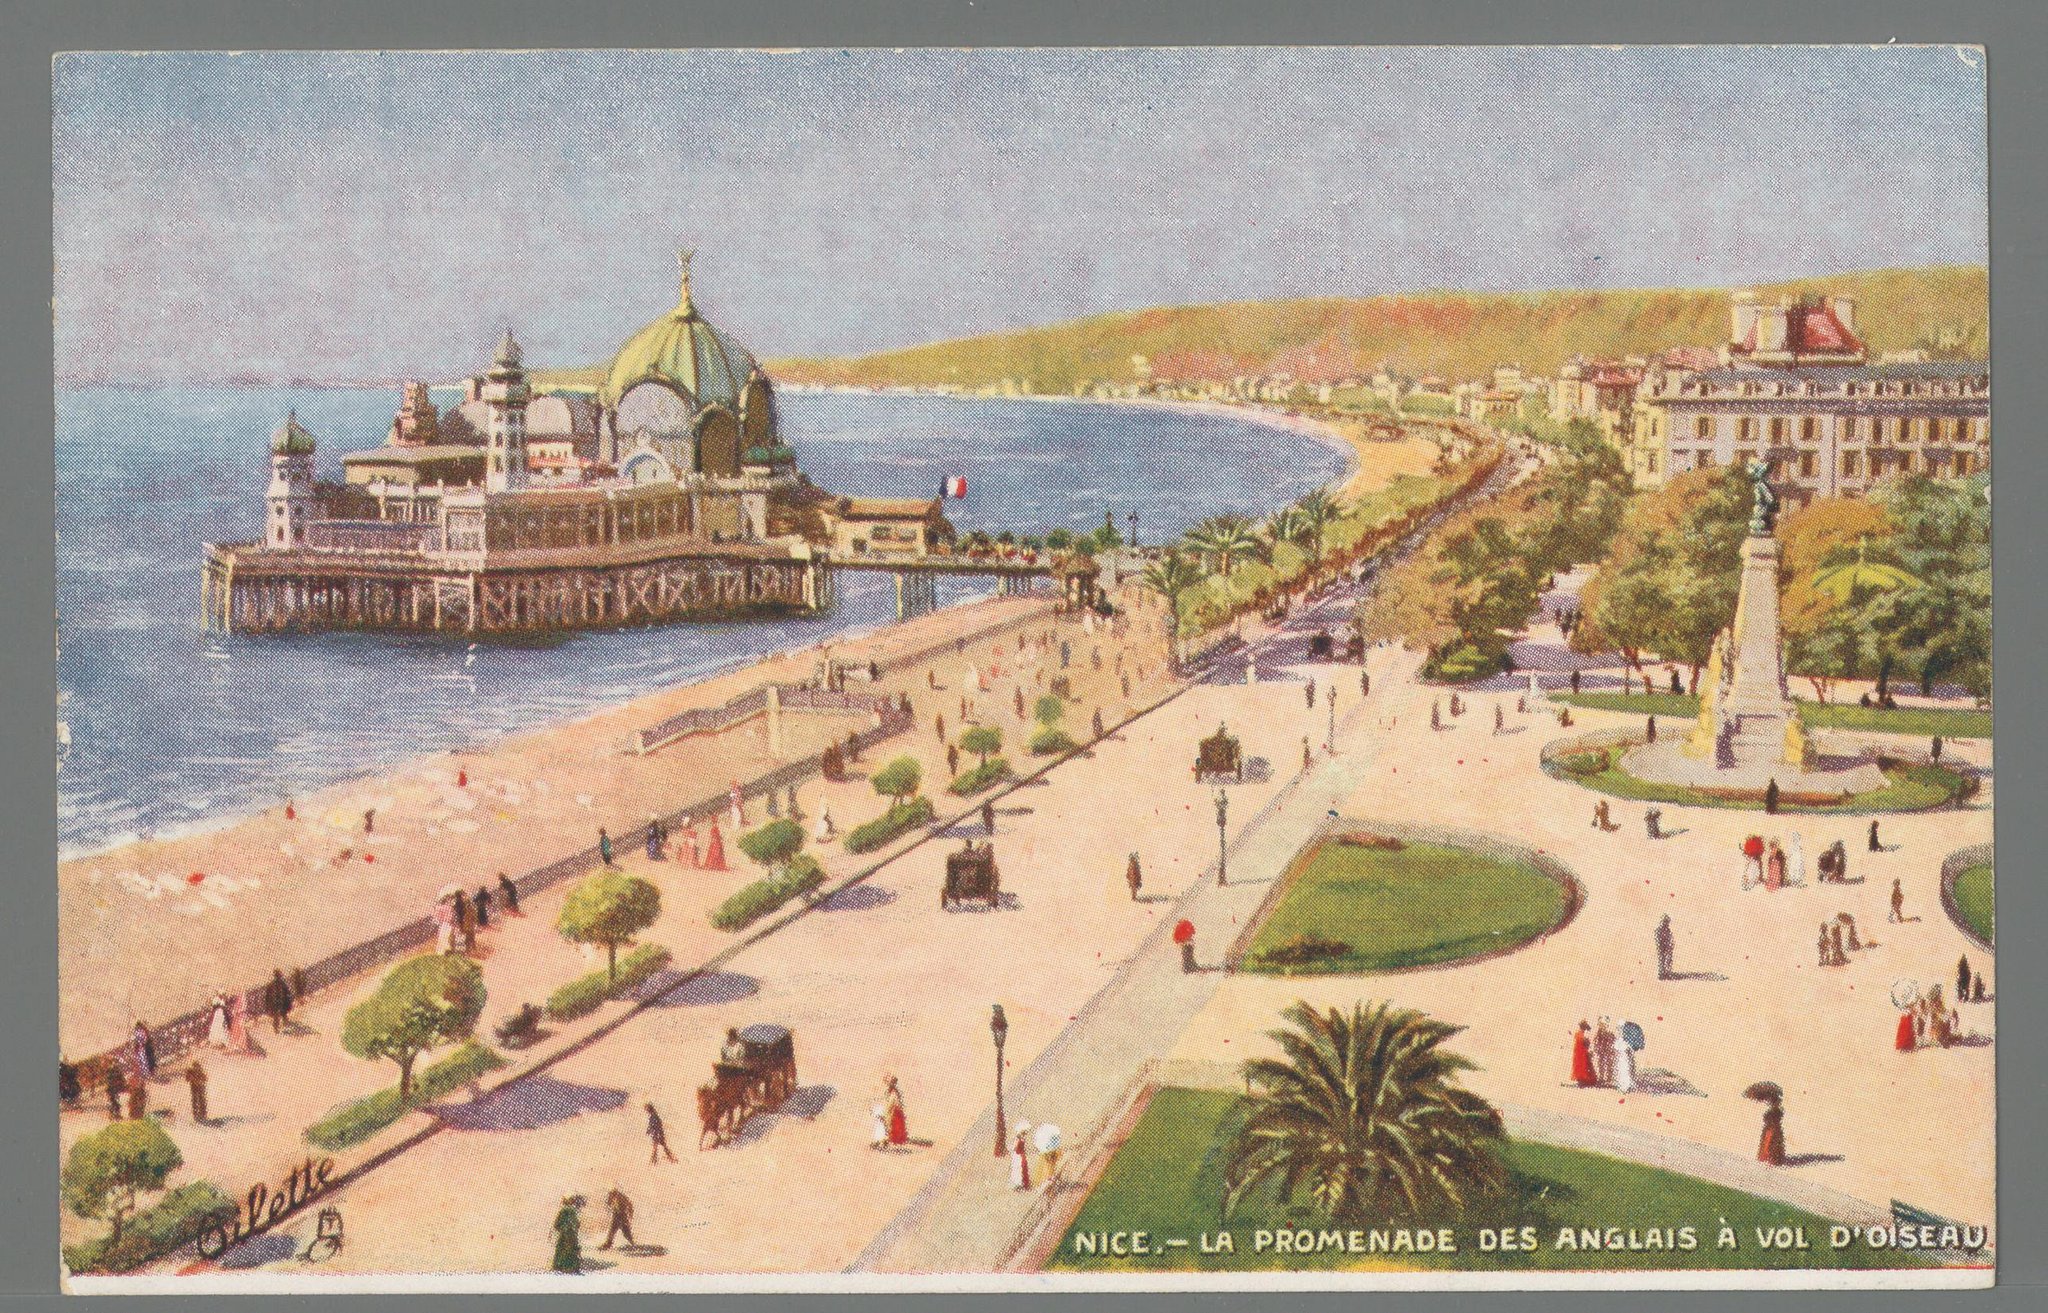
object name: photomechanical print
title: Collection "Villes de France"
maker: Anonymous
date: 1907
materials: cardboard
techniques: writing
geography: nice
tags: avenue, boulevard, promenade, esplanade (+ city(-scape) with figures, staffage), prospect of city, town panorama, silhouette of city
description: Het serienummer op de kaart is 61. De kaart werd verkocht in een set van 6, genummerd 61-66.